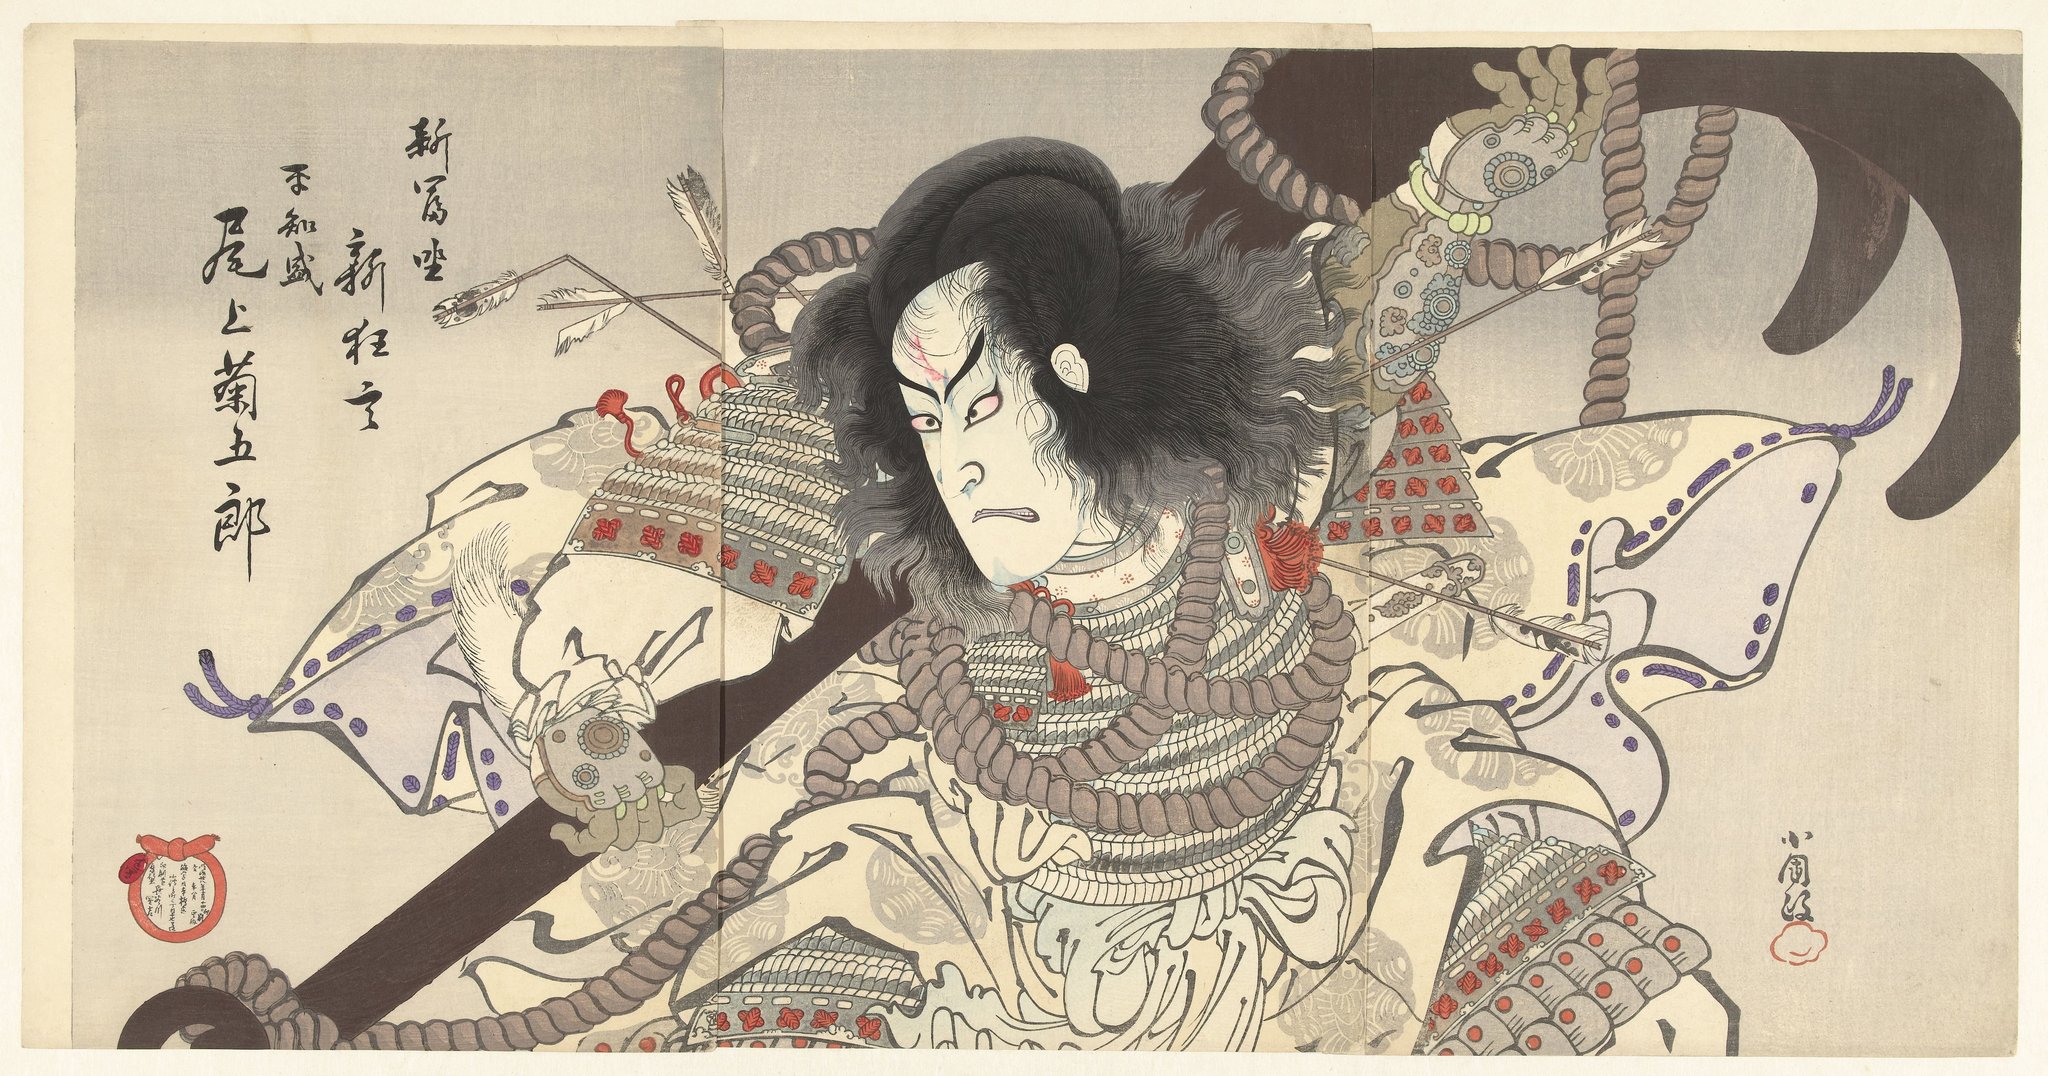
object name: print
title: Onoe Kikugoro als Taira no Tomomori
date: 1895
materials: paper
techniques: blind stamped, woodcut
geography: japan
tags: weapons, portrait of actor, actress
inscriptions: collector's mark: Lugt 2228, collector's mark: Lugt 2760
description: De populaire acteur Onoe Kikugoro V in de rol van generaal Taira no Tomomori, dodelijk gewond zichzelf aan een anker vastbindend om zelfmoord te plegen door van een klif af te springen.